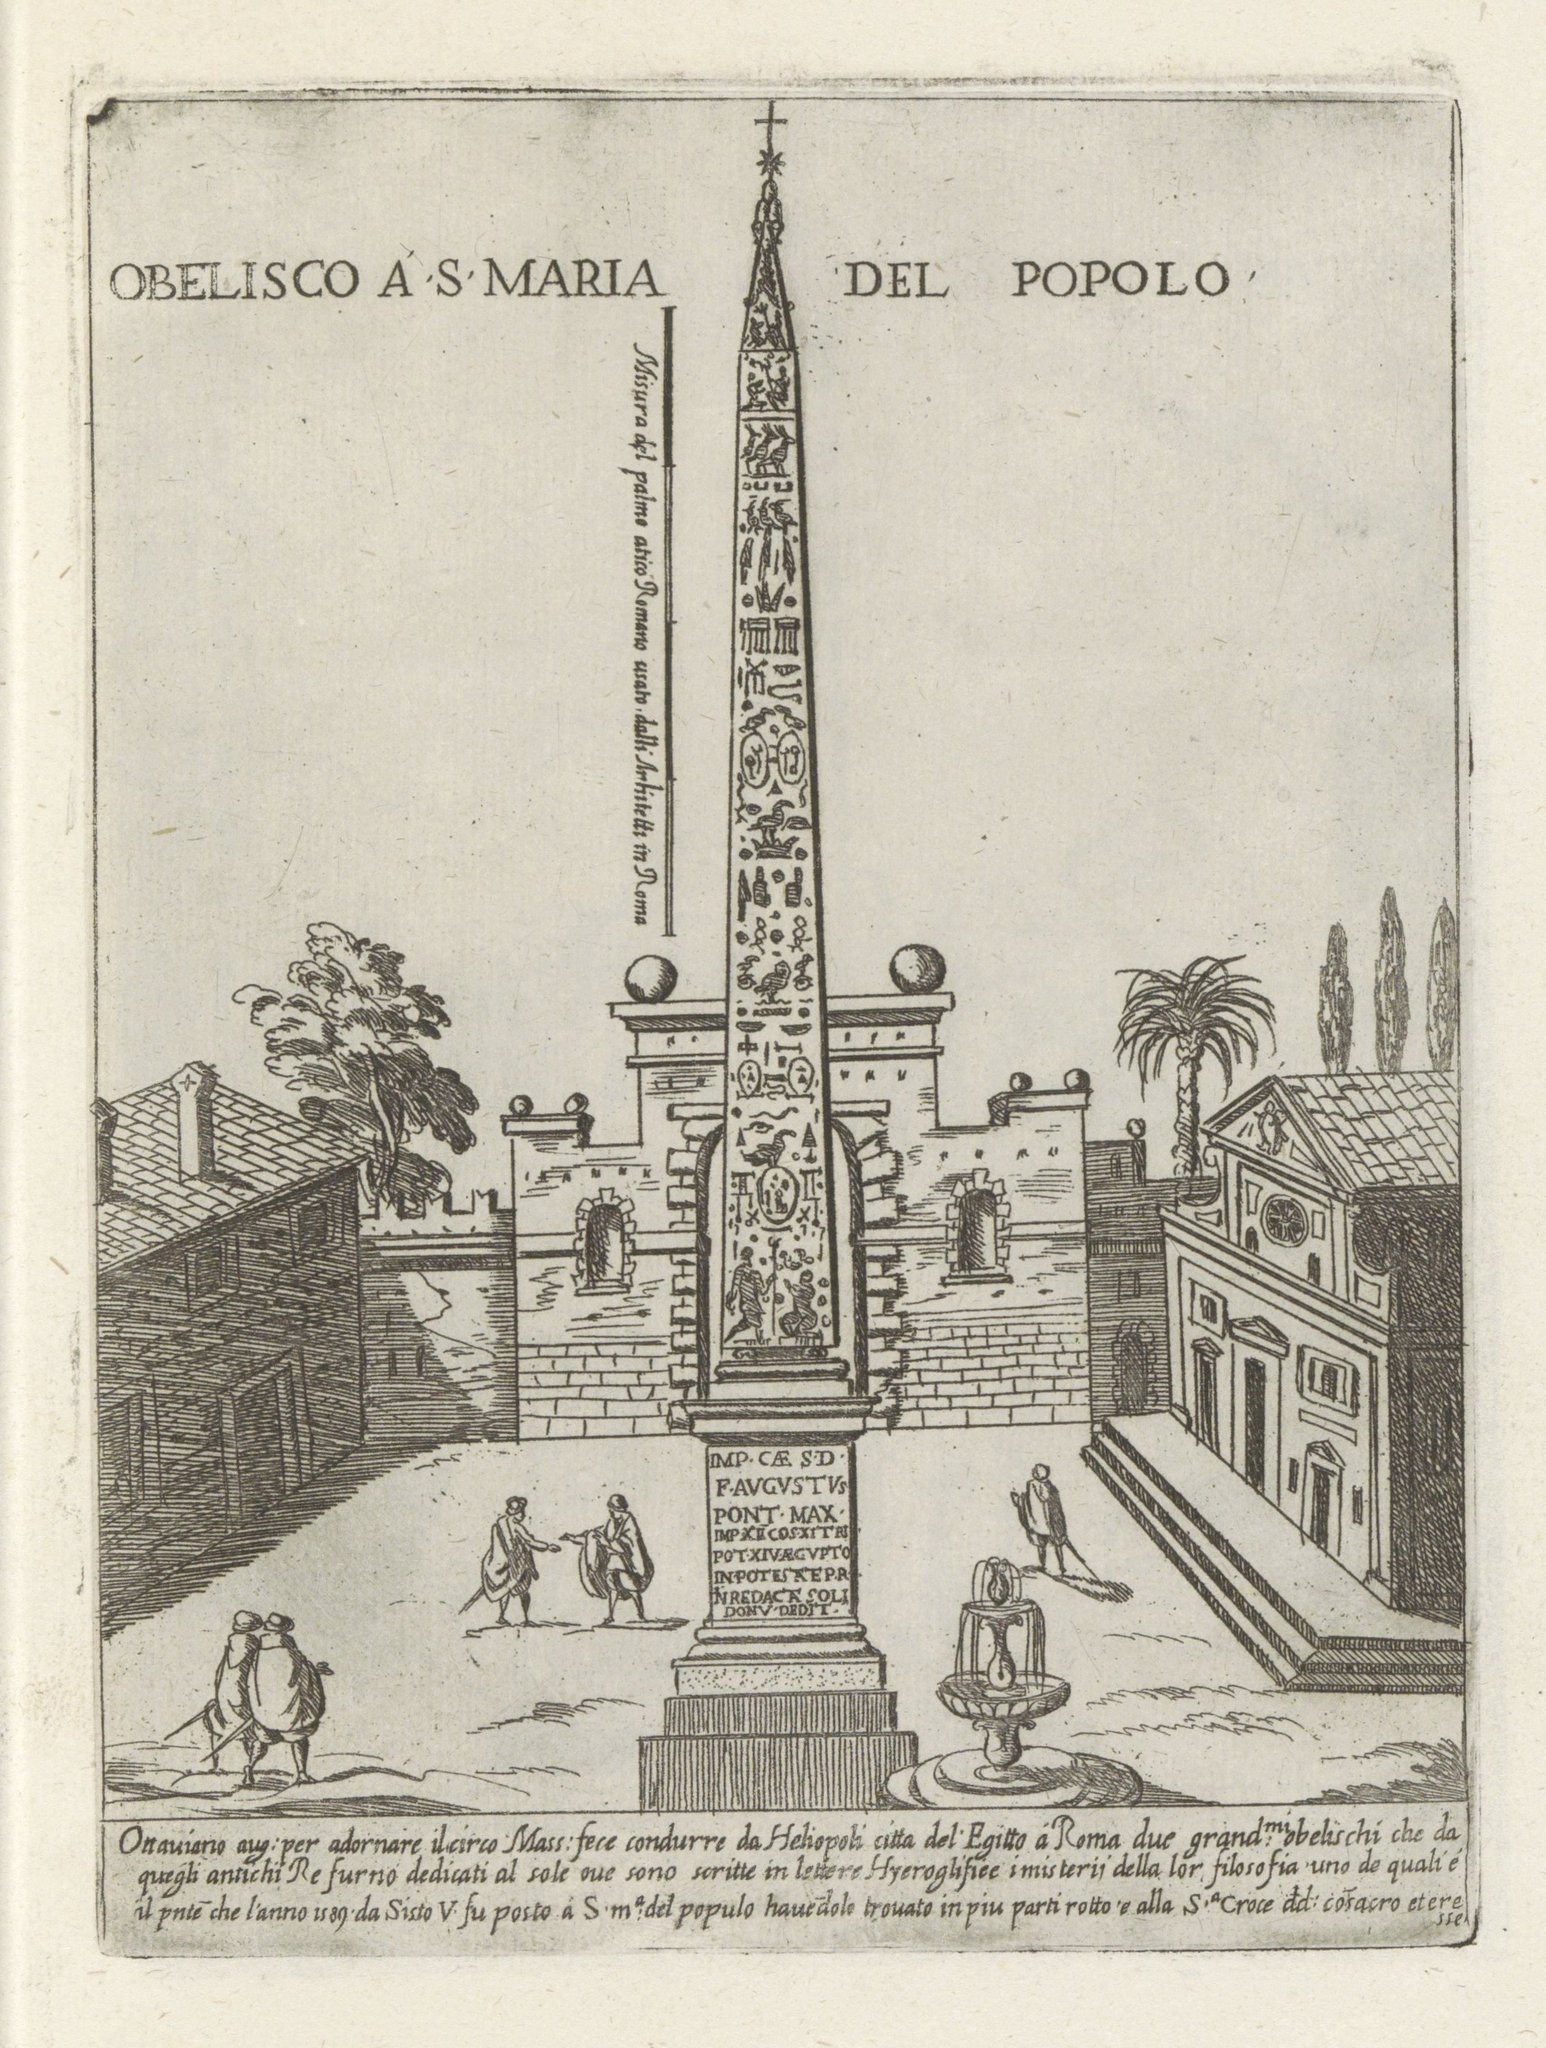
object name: print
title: Ornamenti di fabriche antichi et moderni dell' alma citta di Roma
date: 1576-1618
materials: paper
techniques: etching, intaglio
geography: vatican city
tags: square, place, circus, etc., obelisk, needle, church (exterior), city-gate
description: Tekst in het Italiaans in de ondermarge. De prent maakt deel uit van een album.